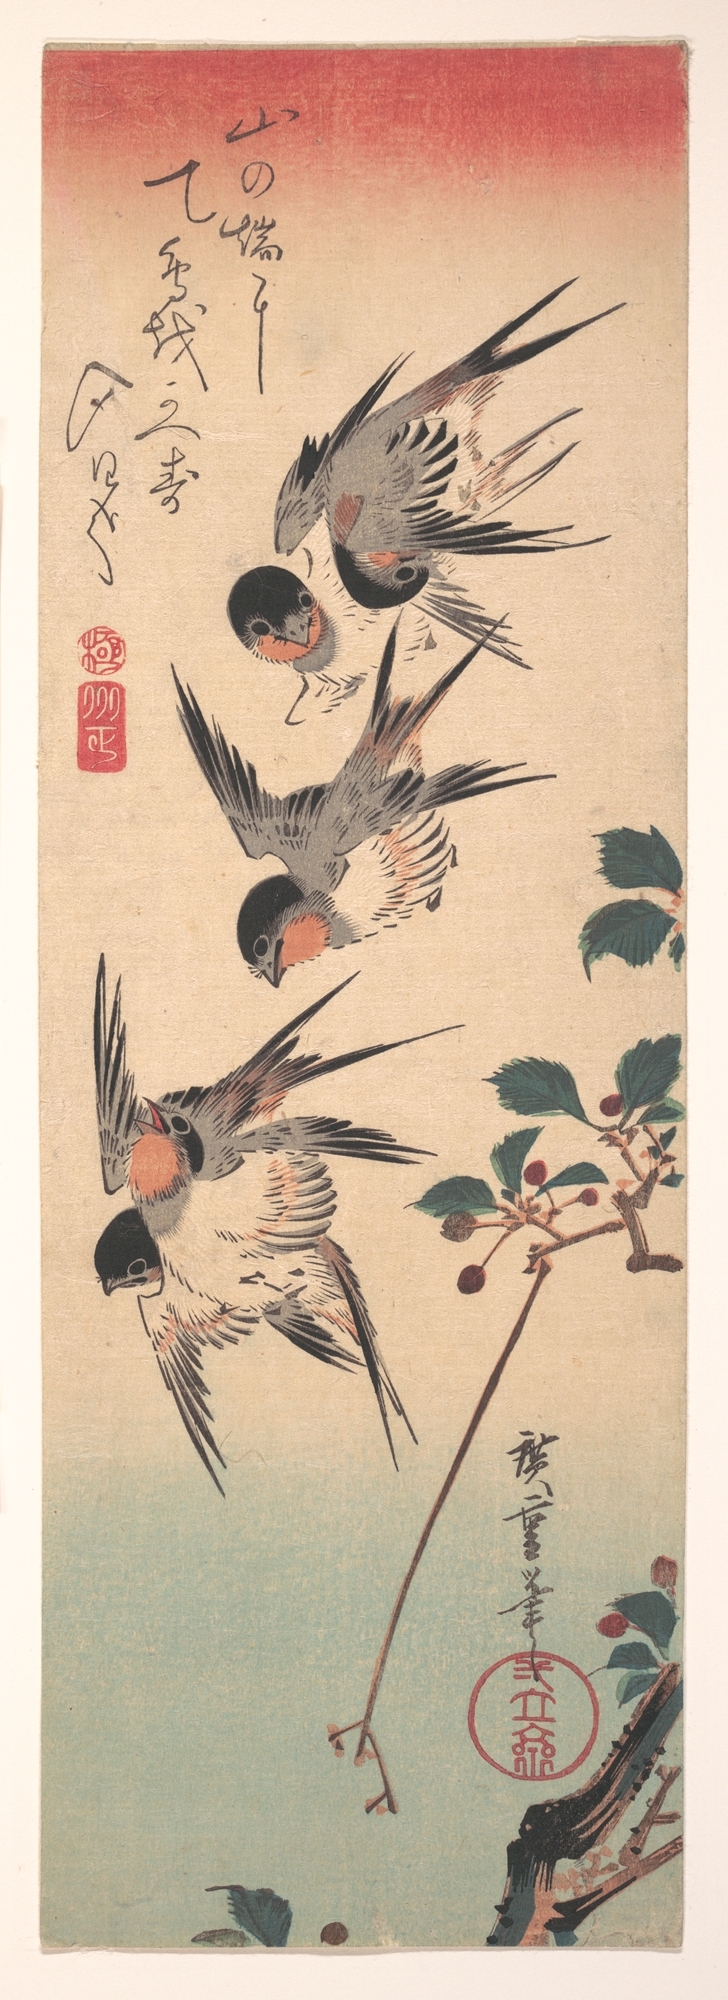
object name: woodblock print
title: Swallows and Budding Wild Cherry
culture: japanese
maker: utagawa hiroshige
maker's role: artist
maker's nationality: japanese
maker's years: 1797-1858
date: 1835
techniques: woodblock print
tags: birds